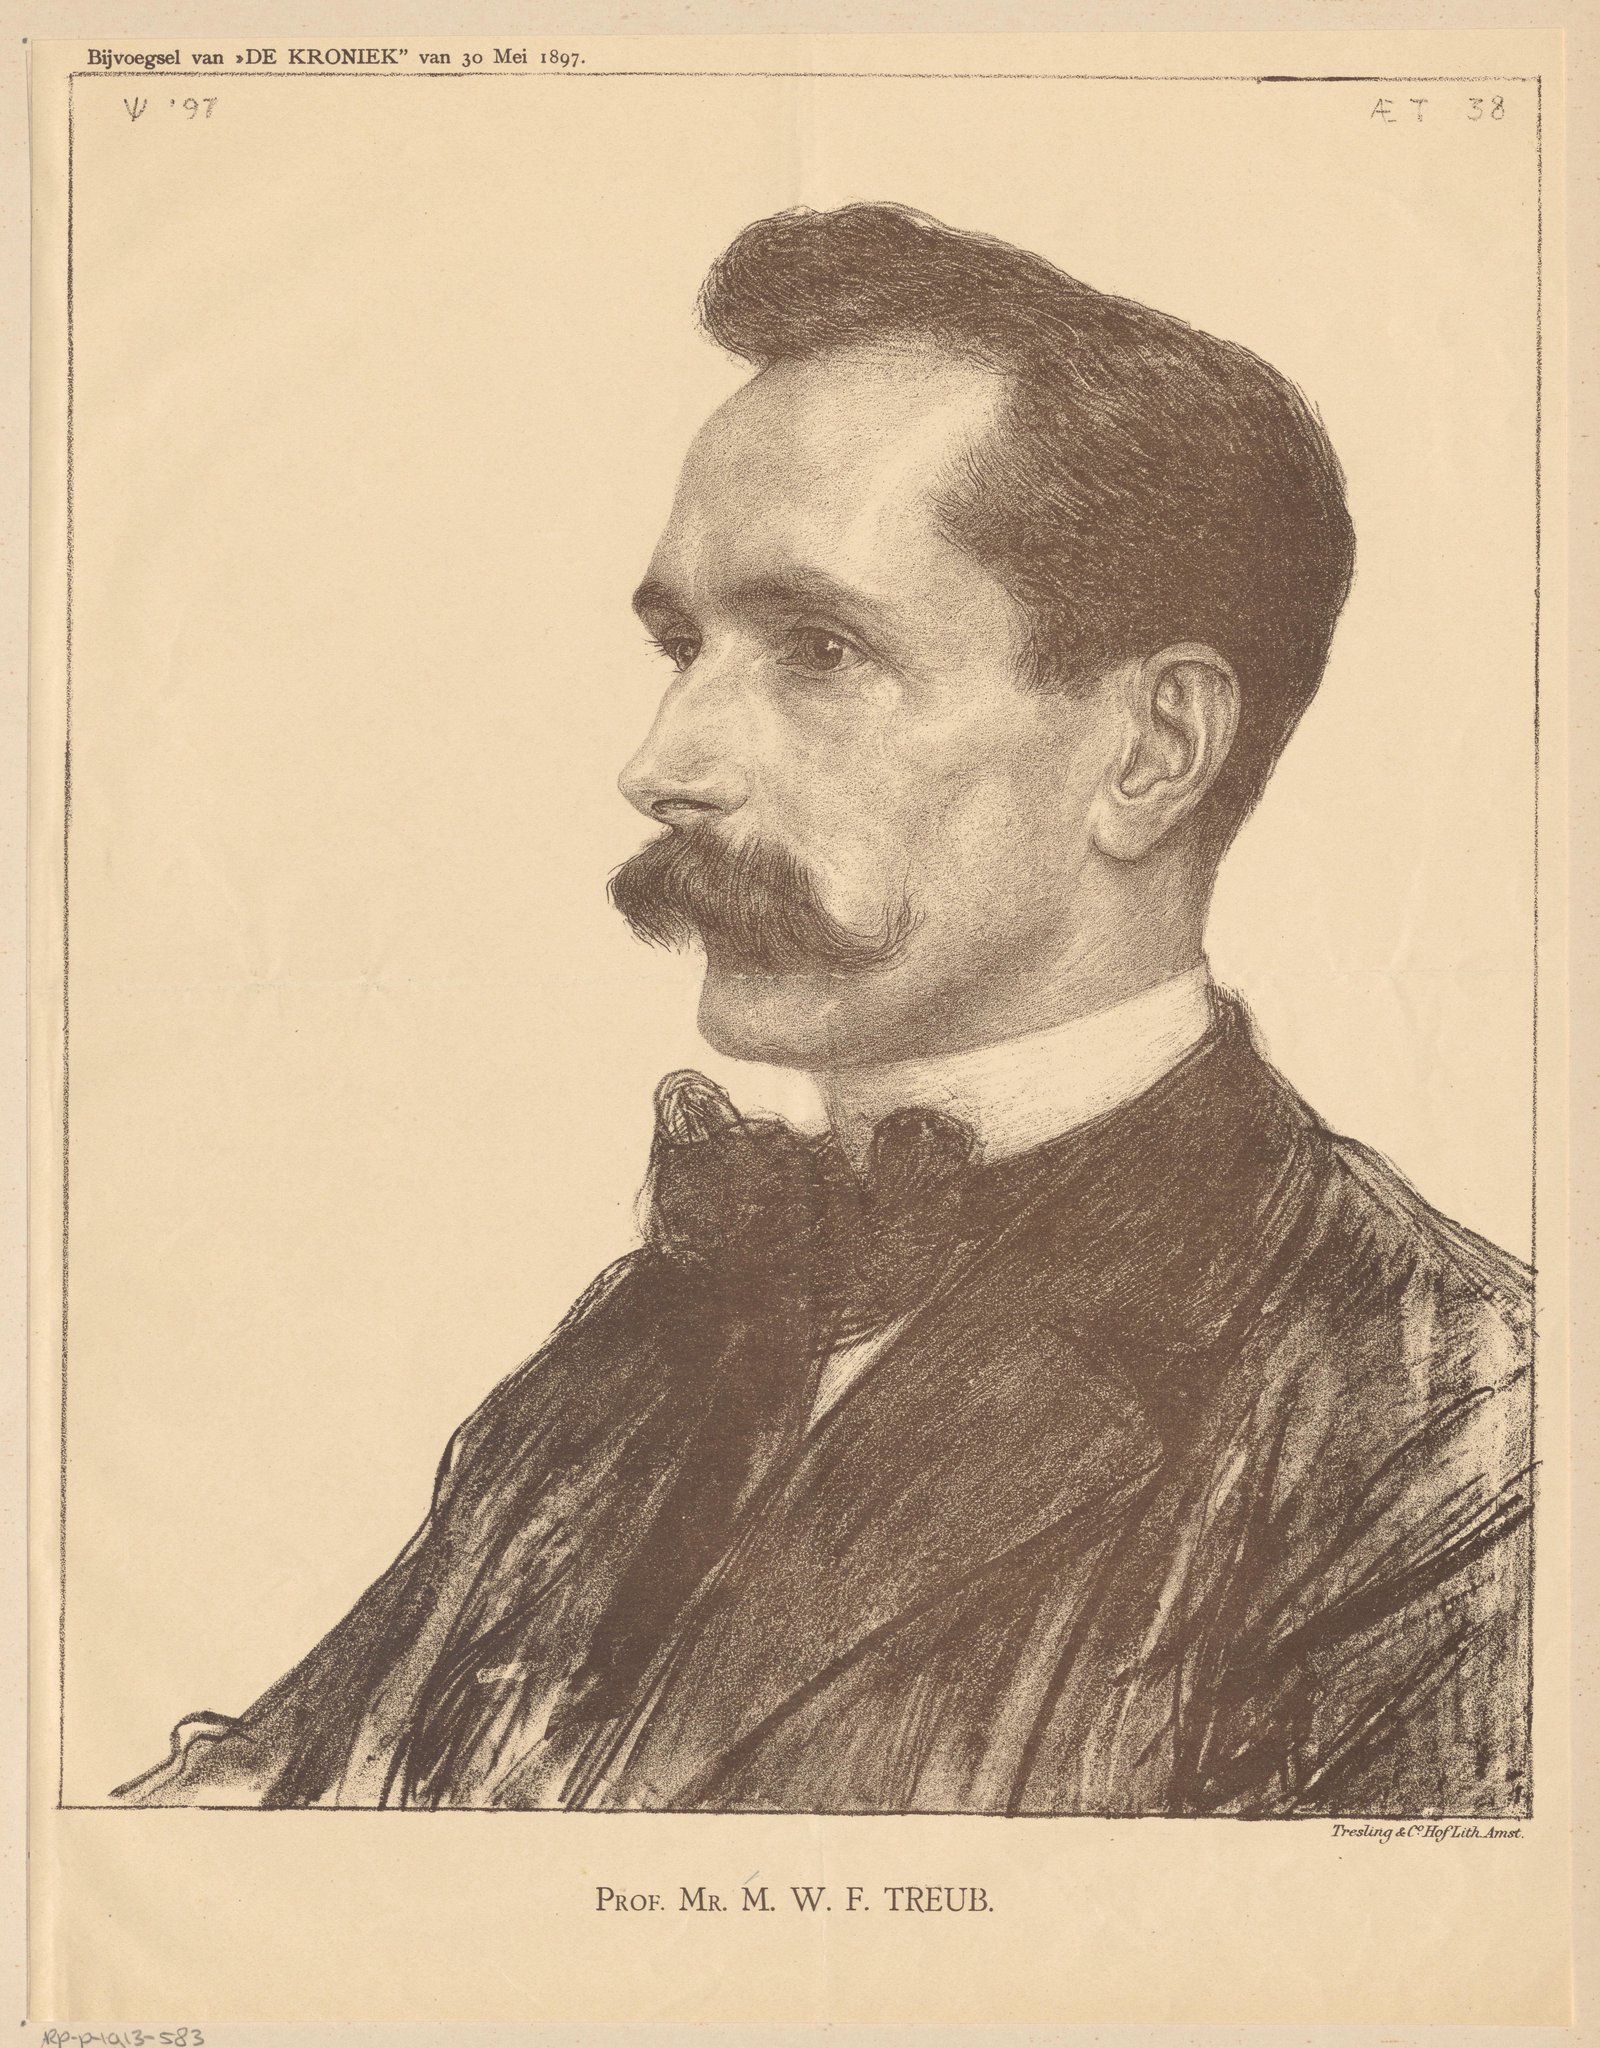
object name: print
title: Portret van Willem Treub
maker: jan veth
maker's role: designer, draughtsman, painter, print maker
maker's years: 1864-1925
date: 1897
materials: paper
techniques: lithograph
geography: netherlands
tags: voorschoten, historical persons, politician, e.g. party leader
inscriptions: collector's mark: Lugt 2233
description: Dit portret werd uitgegeven als bijvoegsel bij De Kroniek op 30 mei 1897.